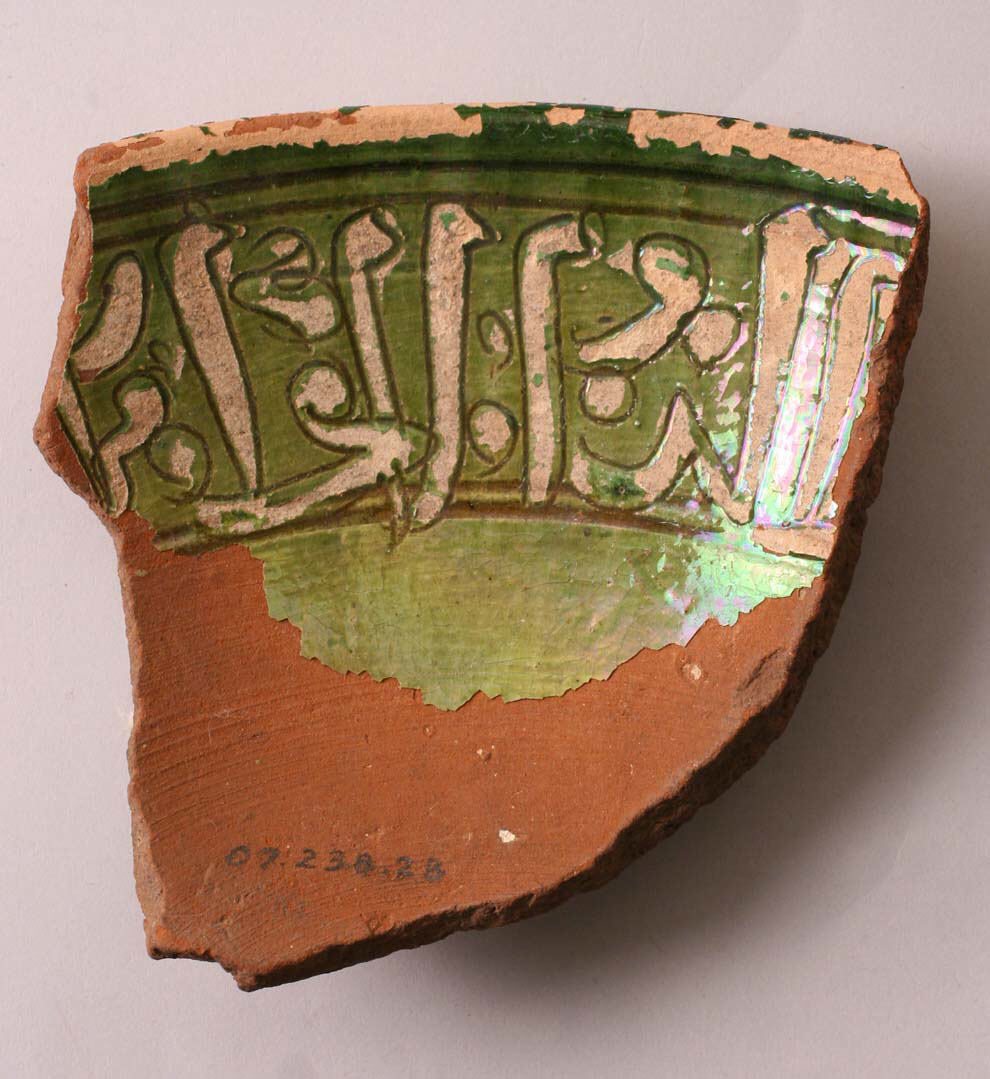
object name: fragment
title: Ceramic Fragment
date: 1301-1500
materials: earthenware, glaze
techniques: incising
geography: egypt